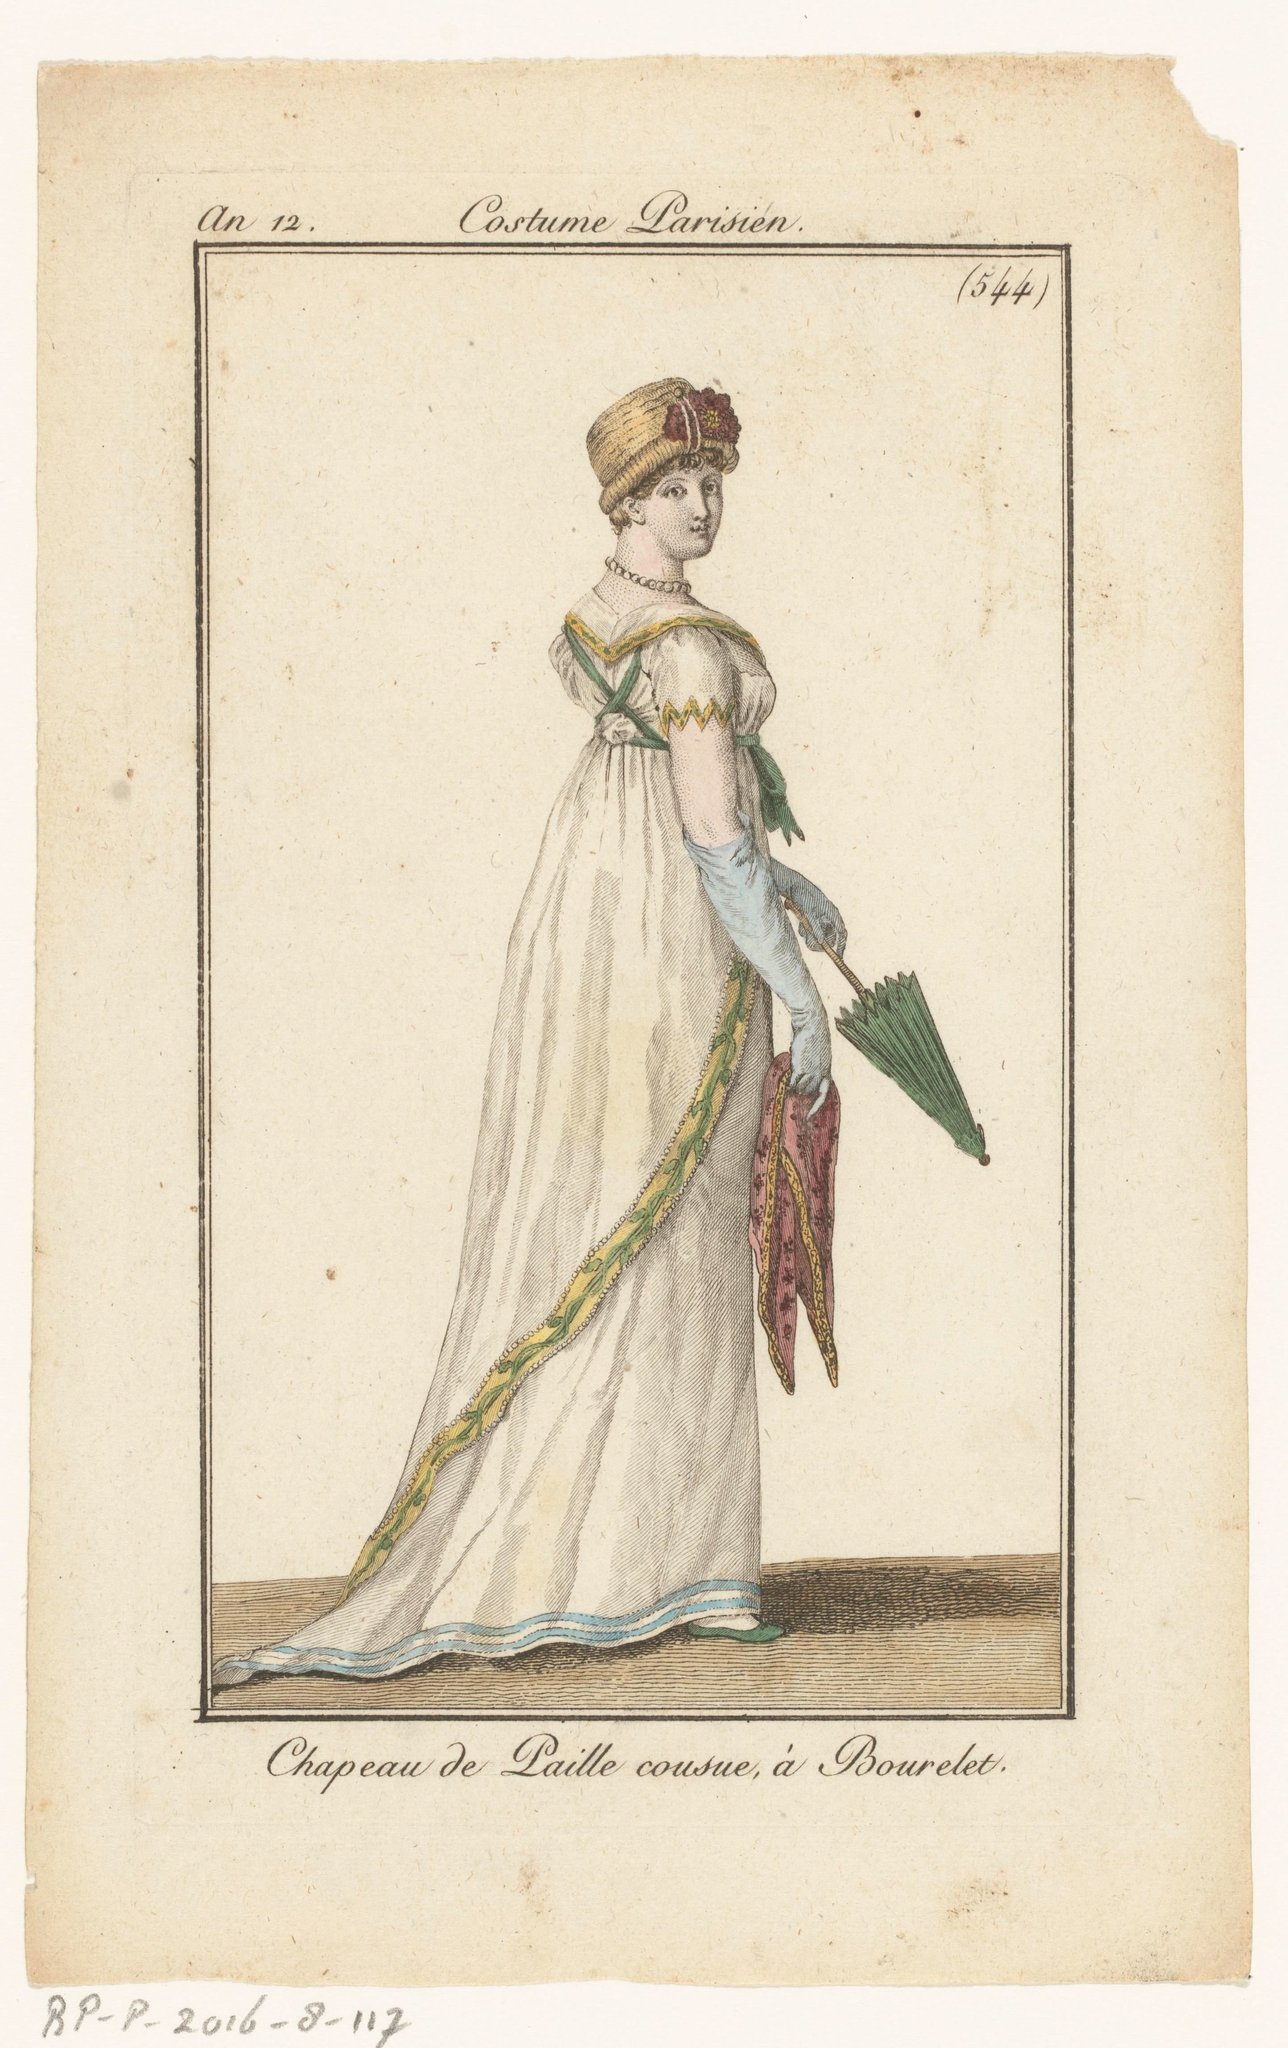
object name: fashion print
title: Journal des Dames et des modes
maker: Anonymous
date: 1803-1804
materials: paper, ink, watercolor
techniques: etching, hand coloring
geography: france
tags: fashion plates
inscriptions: collector's mark: Lugt 2228